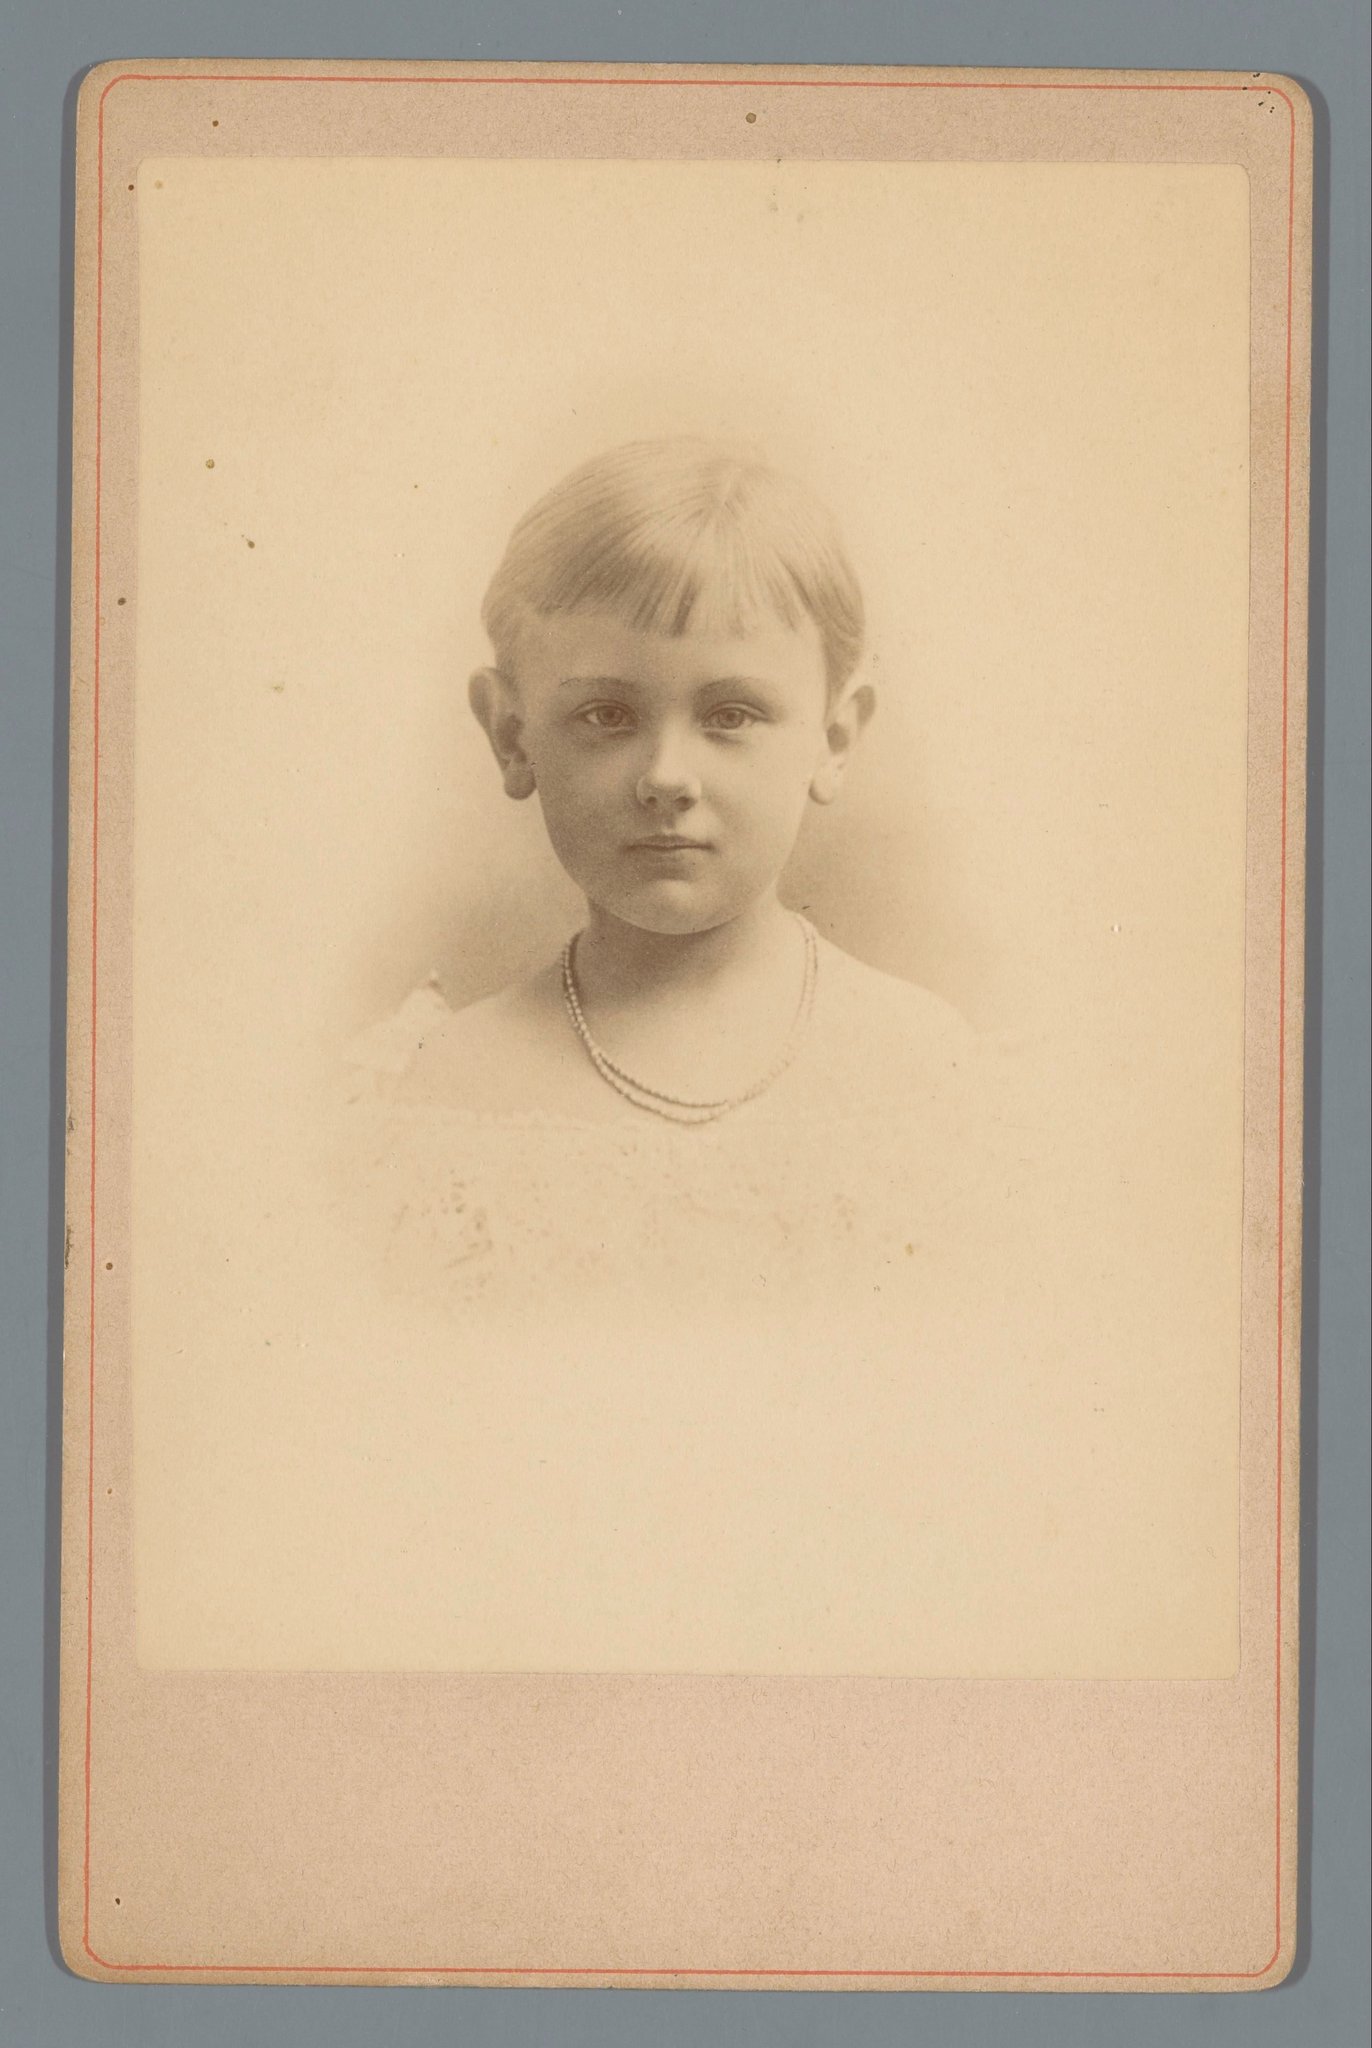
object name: cabinet photograph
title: Portret van prinses Wilhelmina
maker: Anonymous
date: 1883-1885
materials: cardboard, paper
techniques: albumen print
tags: the hague, print maker, wilhelmina of the netherlands, crown princess, historical persons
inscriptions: inscription: ‘Wilhelmina 1886?’